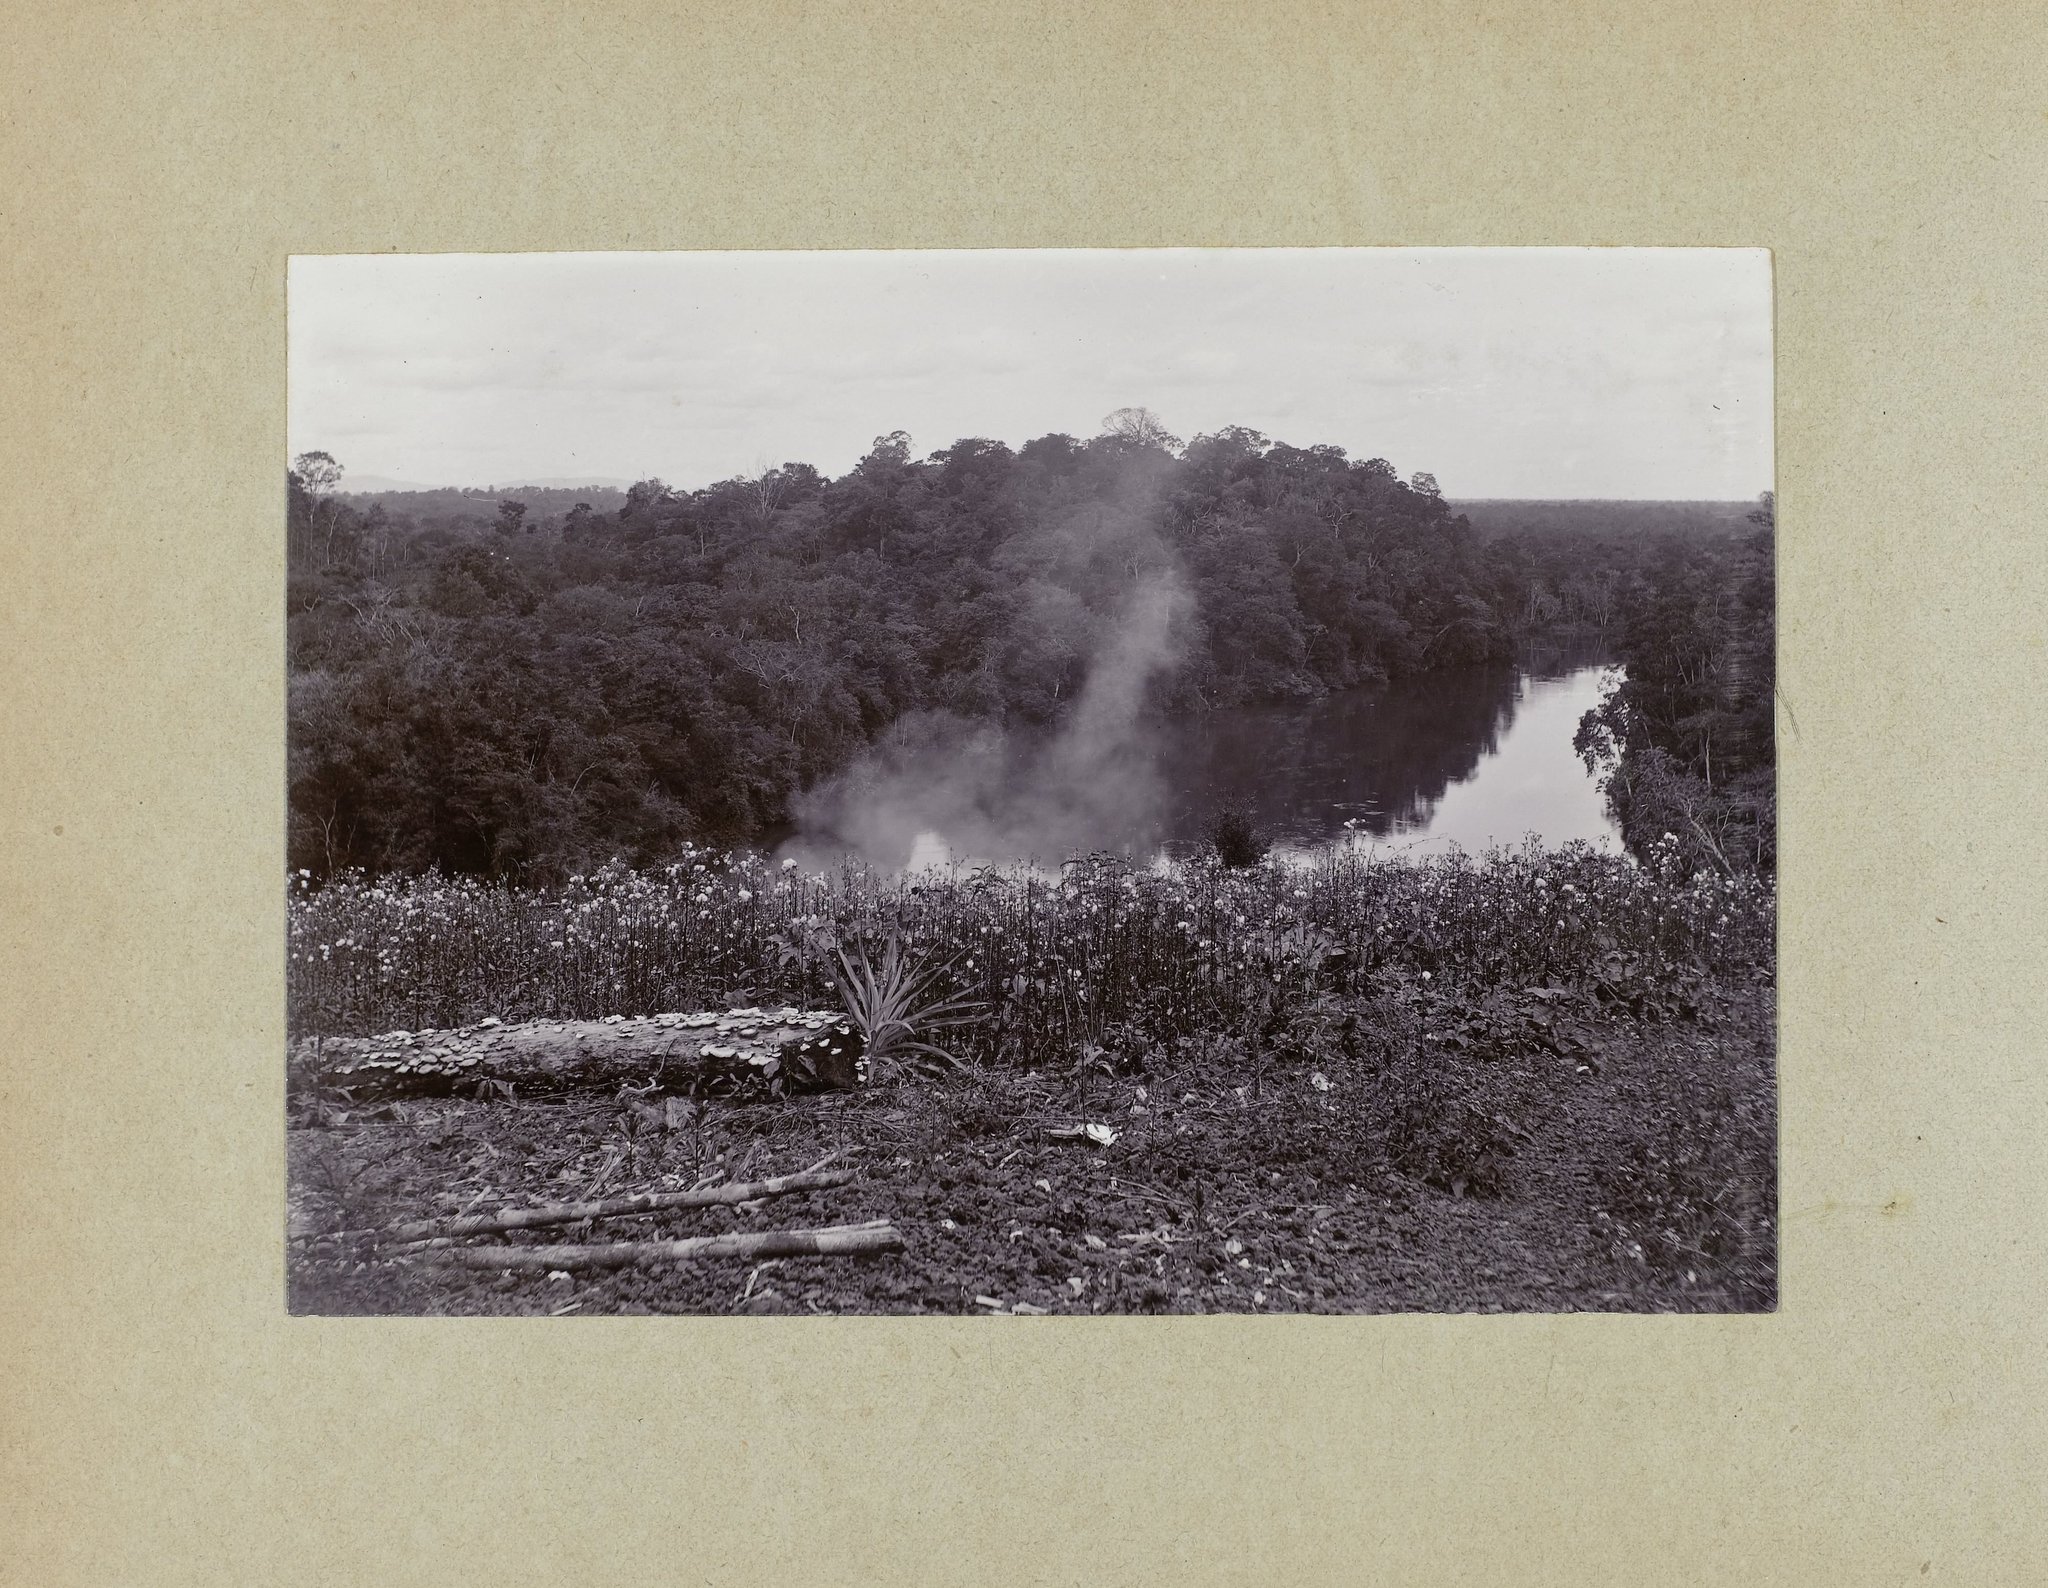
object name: photograph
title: Rivierlandschap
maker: augusta curiel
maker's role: fotograaf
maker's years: 1873-1937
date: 1905-1910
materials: photographic support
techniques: photography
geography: suriname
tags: jacob evert wesenhagen, railway, tramway; rack railway, suriname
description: Landschap met oerwoud en rivier. Foto in het fotoalbum over de aanleg van de Lawaspoorweg in Suriname in de jaren 1903-1912. Onderdeel van een groep objecten afkomstig van de familie Wesenhagen in Suriname.